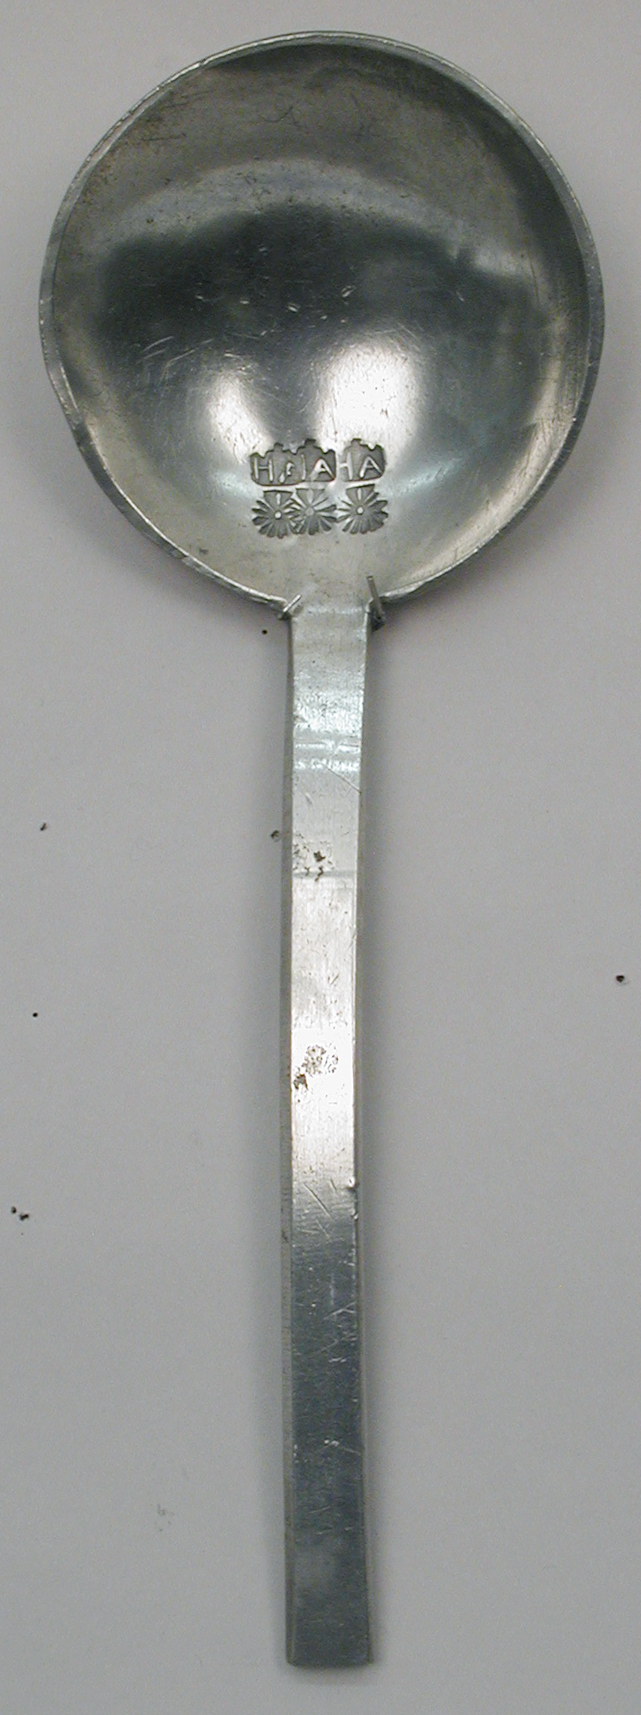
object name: spoon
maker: harm amsing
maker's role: maker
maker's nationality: dutch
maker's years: 1849-1905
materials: pewter